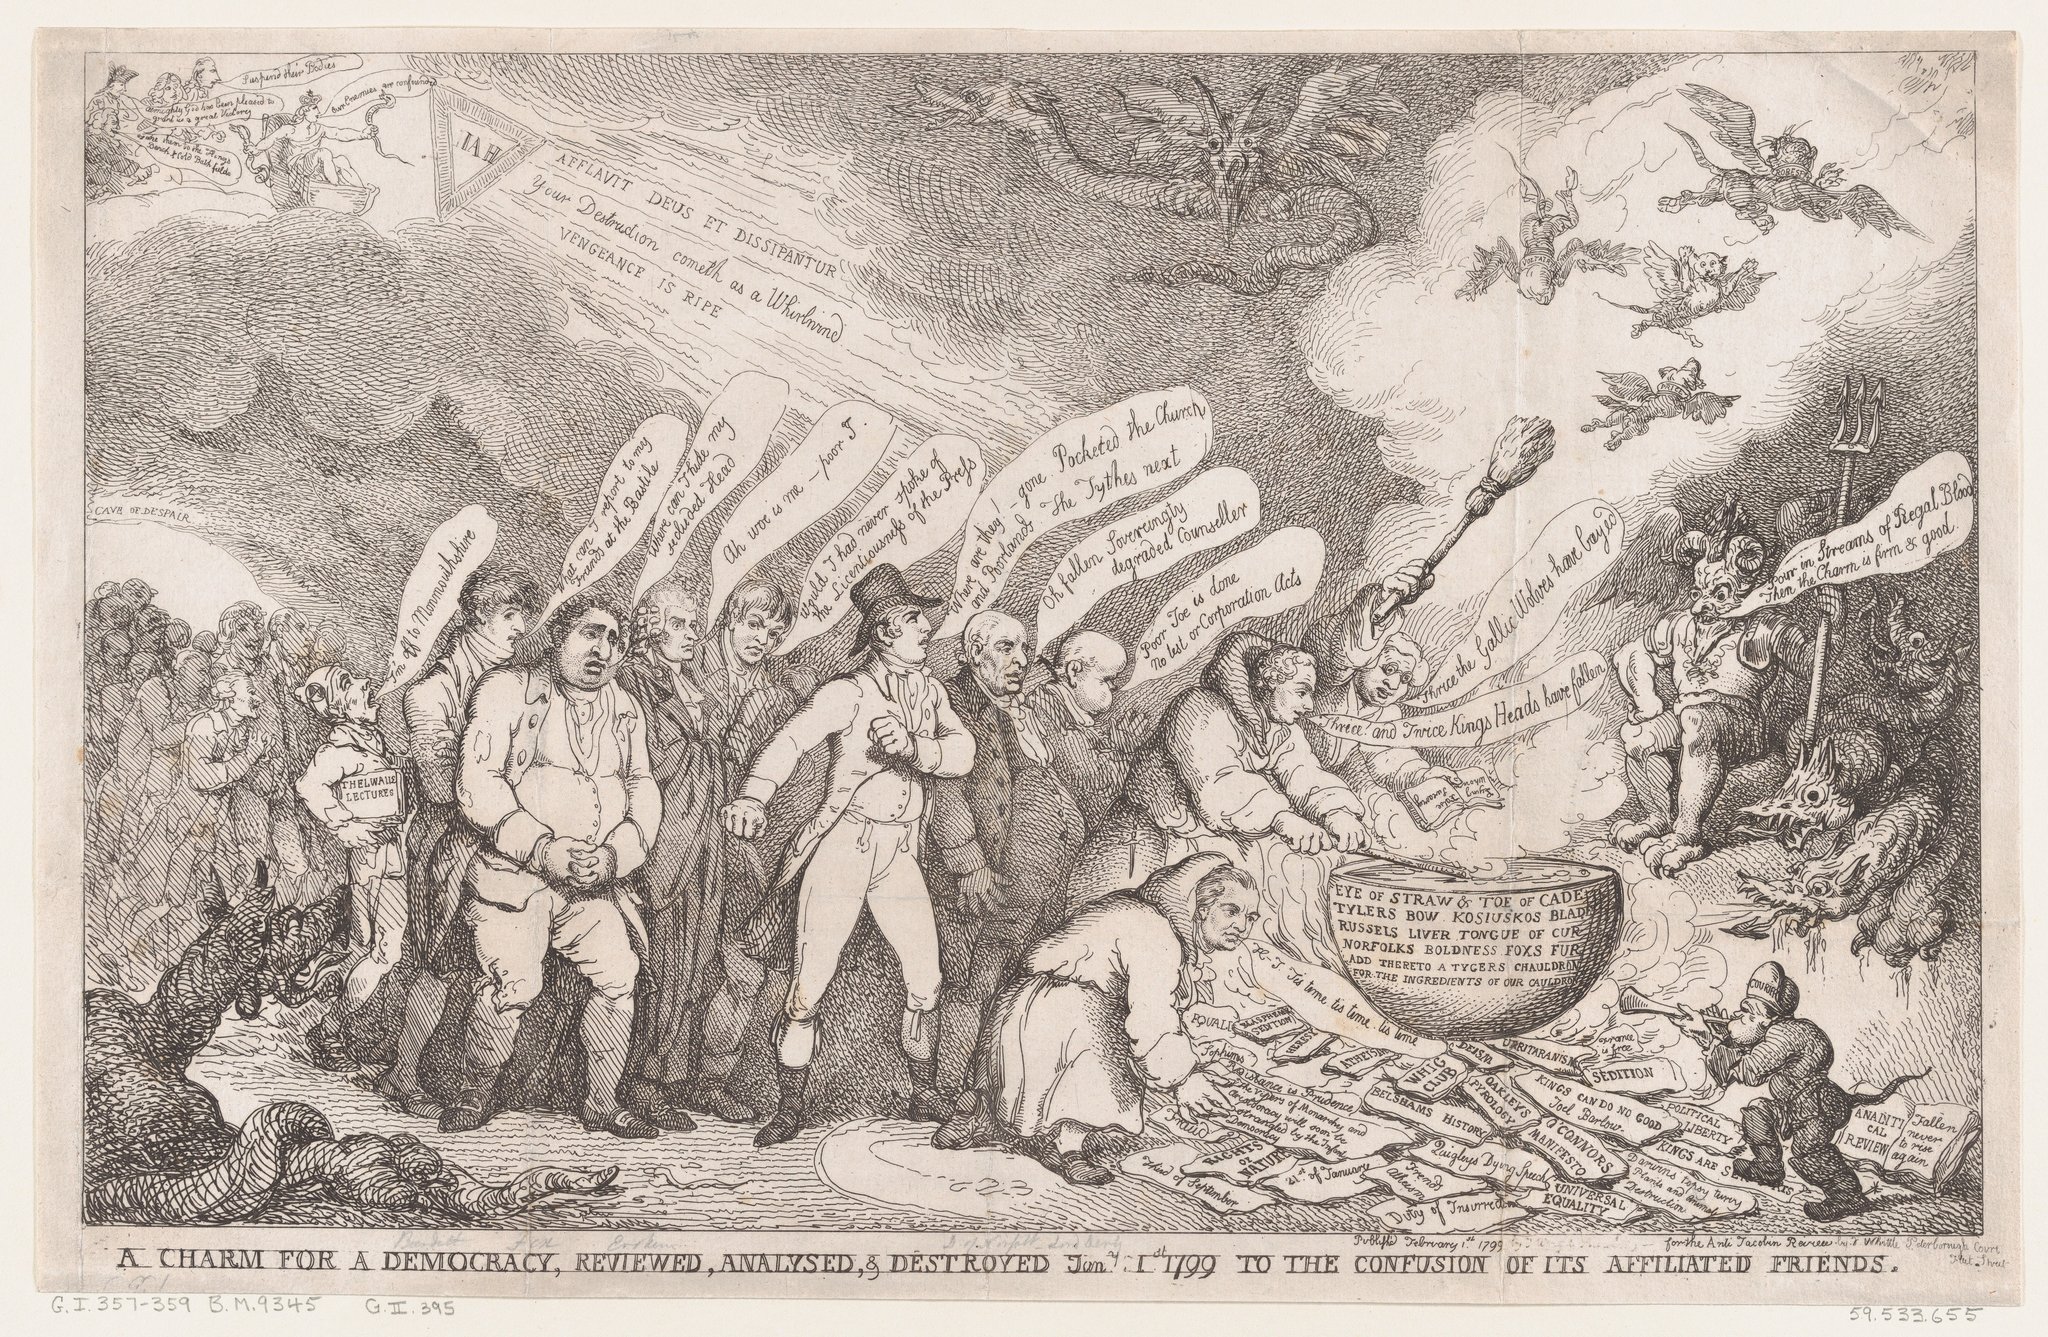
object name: print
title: A Charm for a Democracy, Reviewed, Analysed, & Destroyed Jan 1 1799 to the Confusion of its Affiliated Friends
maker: henri merke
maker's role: artist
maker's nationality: swiss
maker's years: 1760-1820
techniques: etching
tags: men,dragons